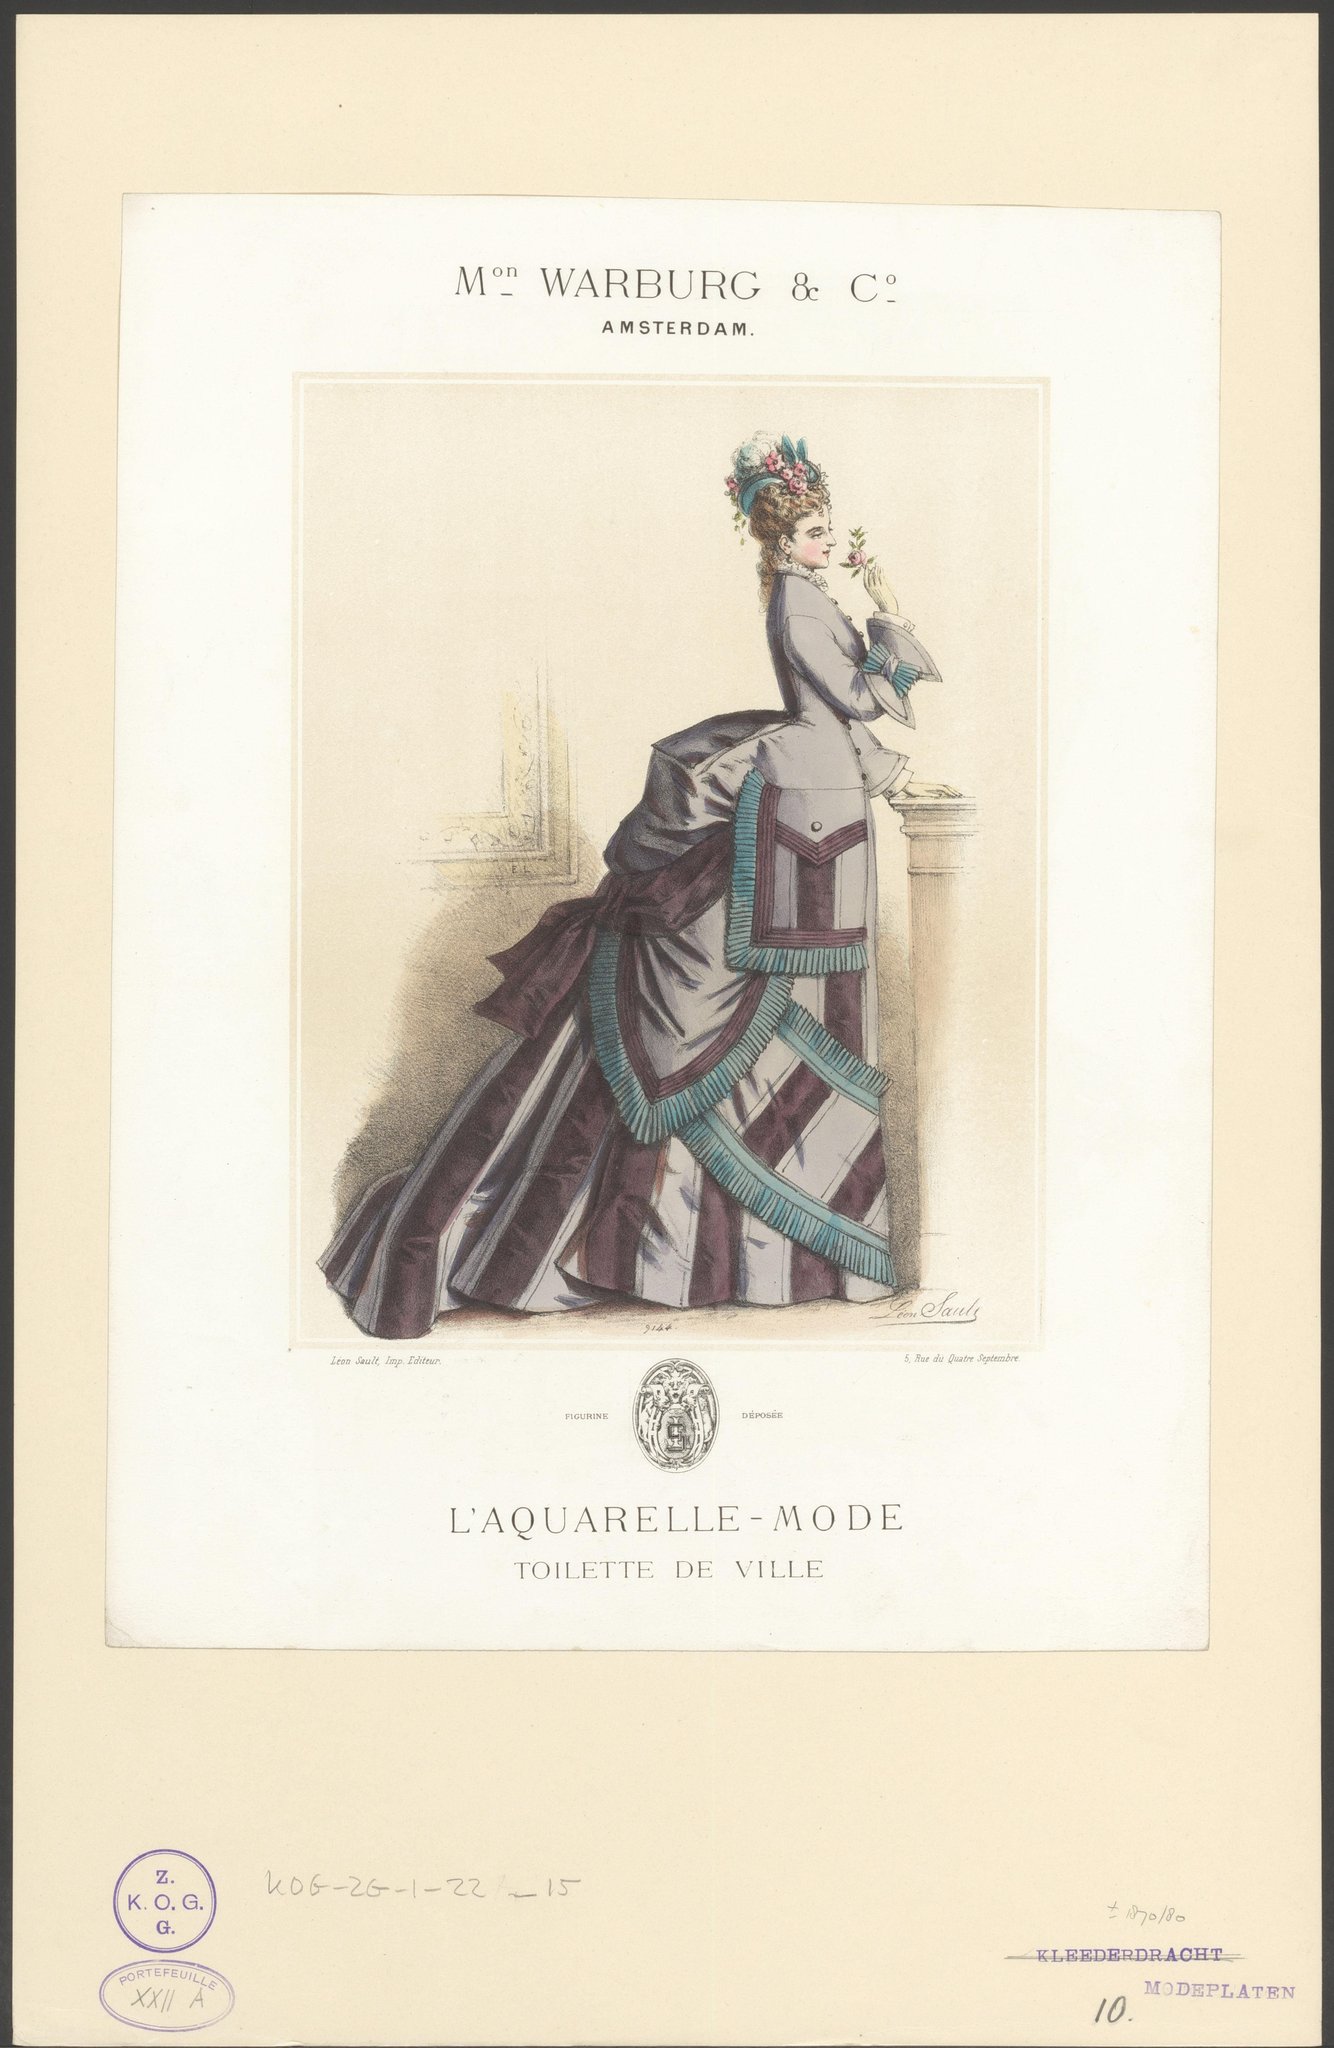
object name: print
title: Vrouw in paarse japon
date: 1875-1886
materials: lacquer, paper, watercolor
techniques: hand coloring, lacquer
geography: paris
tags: fashion plates, clothes, costume (+ women's clothes), dress, gown (+ women's clothes)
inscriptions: collector's mark, collector's mark: Lugt 1641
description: Vrouw in paarse japon, staande naar rechts, ruikend aan een roos. man. Met vermelding van 'Mon. Warburg & Co. Amsterdam'. Prent uit het modetijdschrift L'Aquarelle-Mode (1866-1892). nr. 9144. Onderwerpsrubrieken binnen de Atlas Zeden en Gewoonten: De Kleeding, Modeplaten.